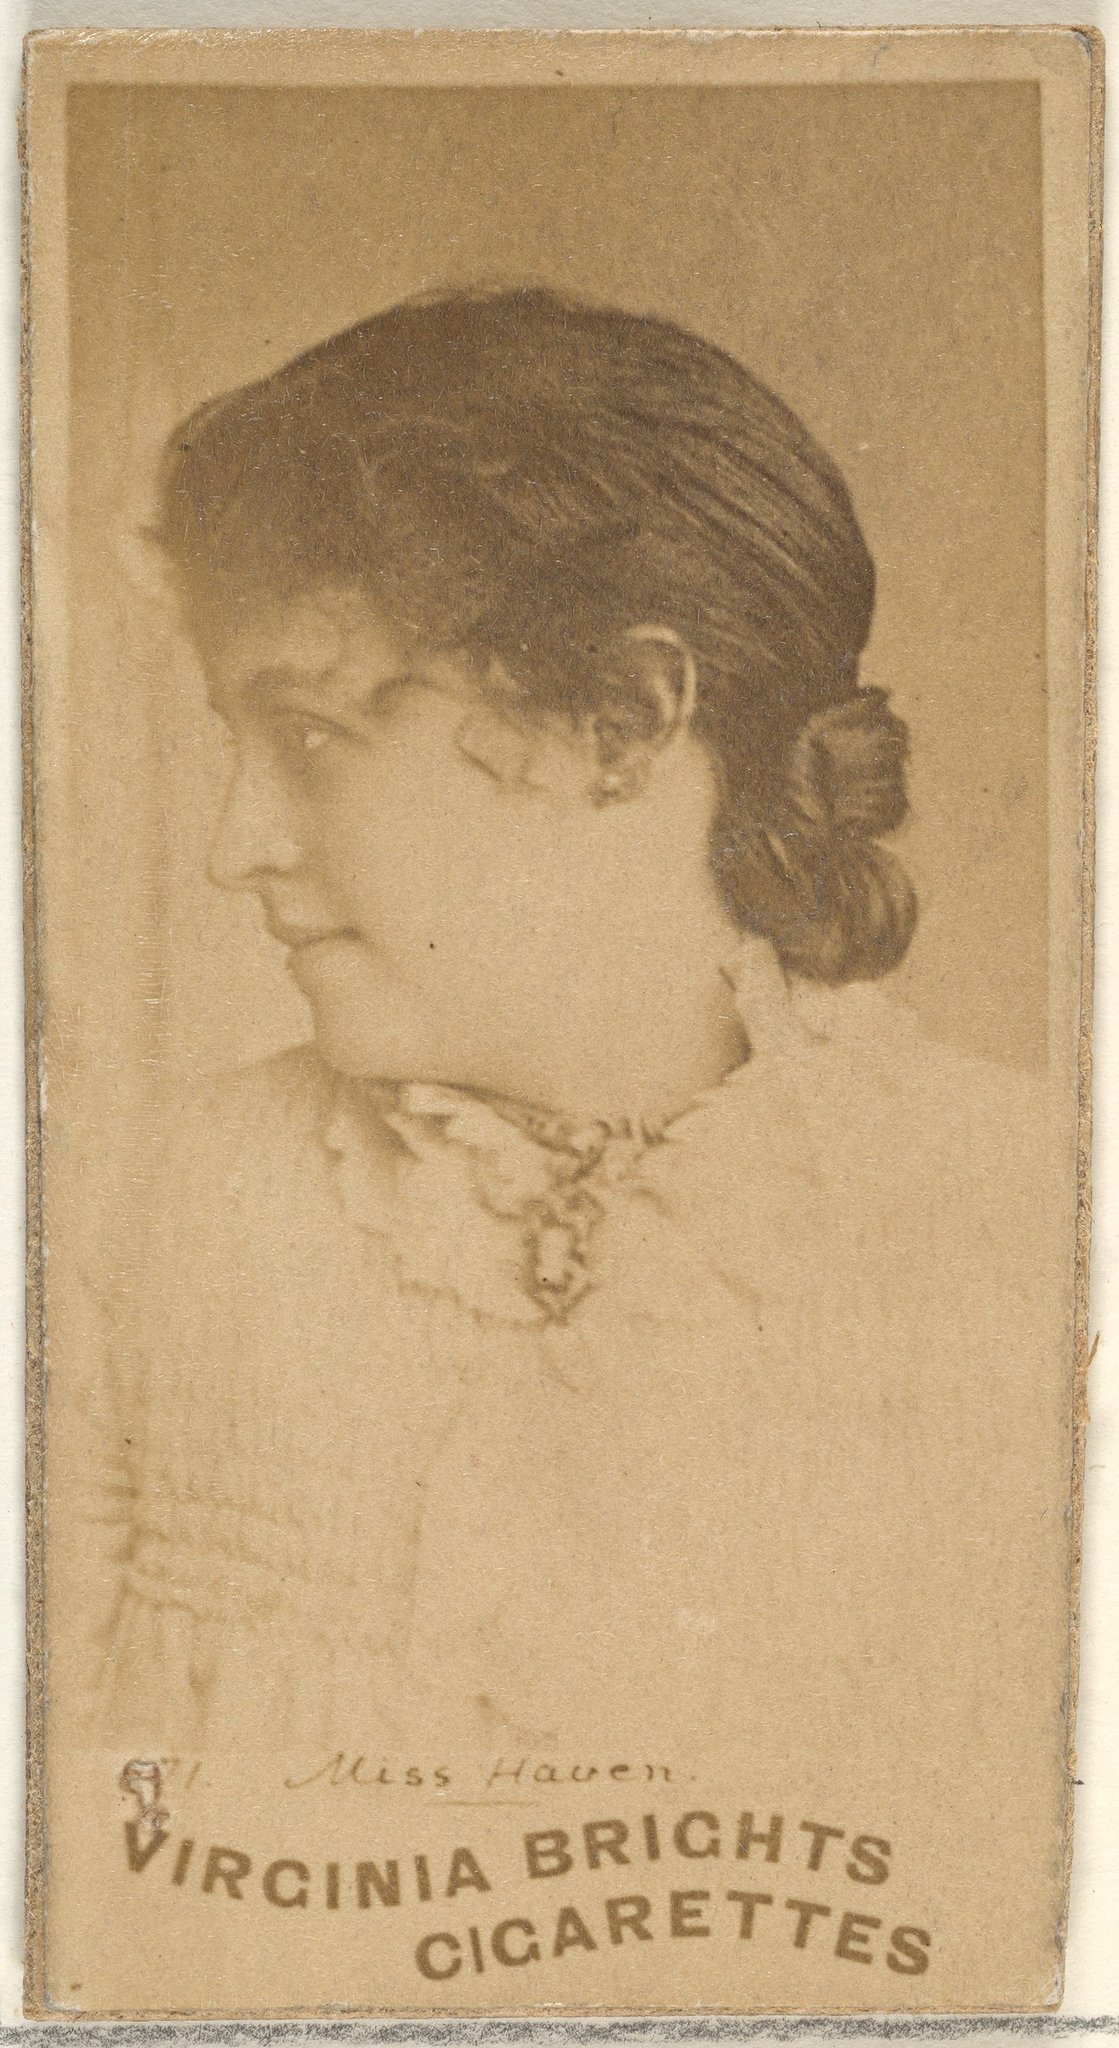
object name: photograph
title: Miss Haven, from the Actors and Actresses series (N45, Type 1) for Virginia Brights Cigarettes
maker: allen & ginter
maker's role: publisher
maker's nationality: american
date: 1888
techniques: albumen silver print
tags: women,actresses